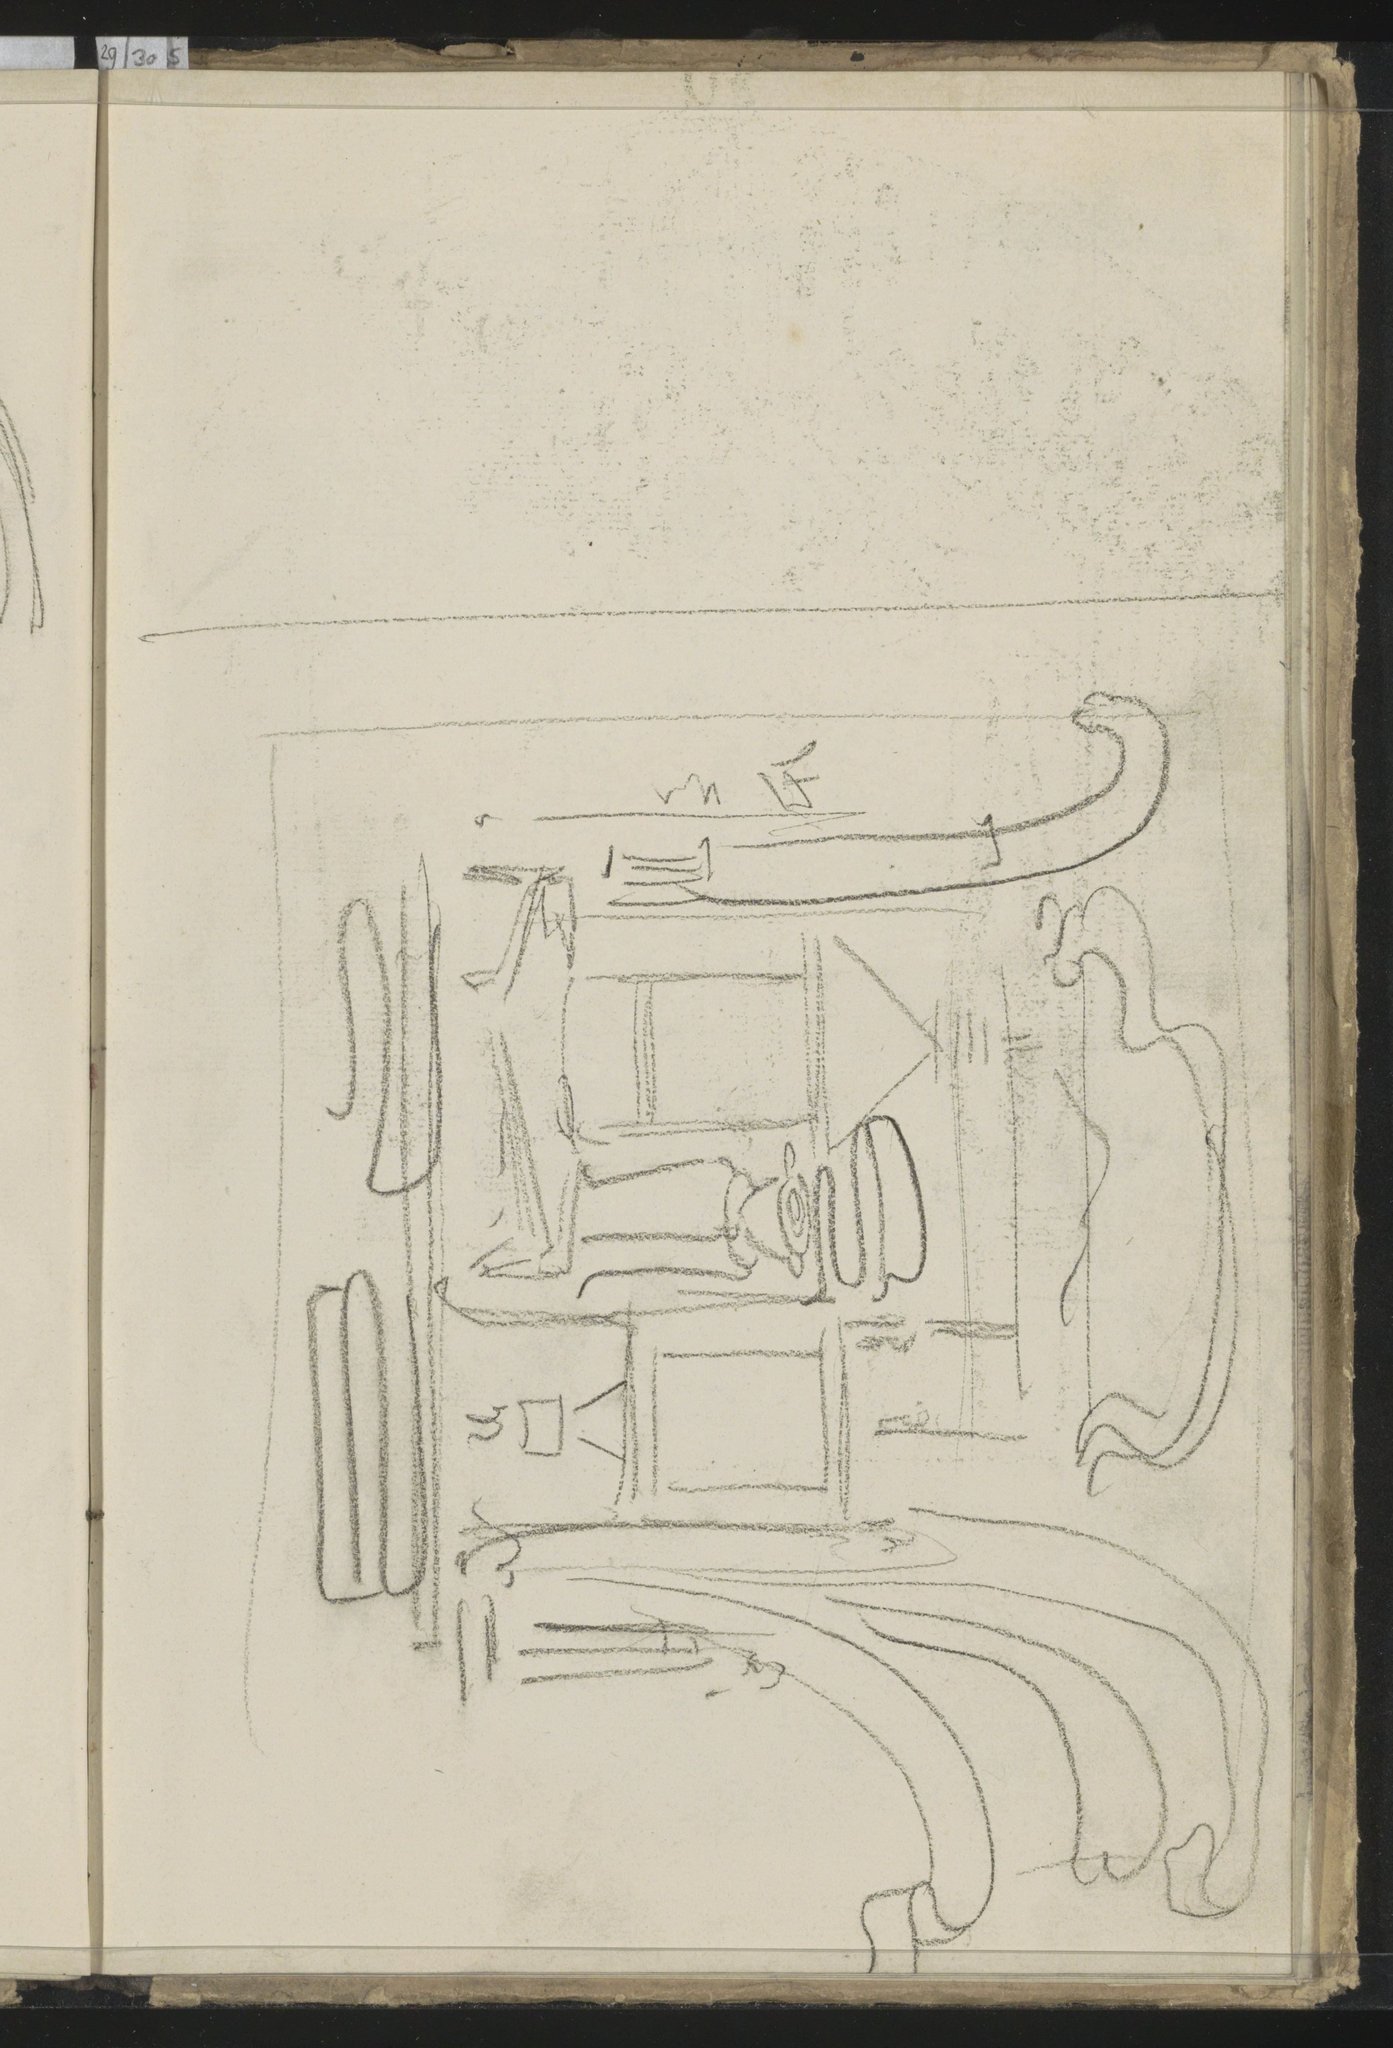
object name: sketchbook leaf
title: Architectuurstudies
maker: carel adolph lion cachet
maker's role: draughtsman, print maker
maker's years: 1864-1945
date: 1890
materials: chalk, paper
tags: architecture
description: Blad 27 recto uit een schetsboek met 38 bladen.